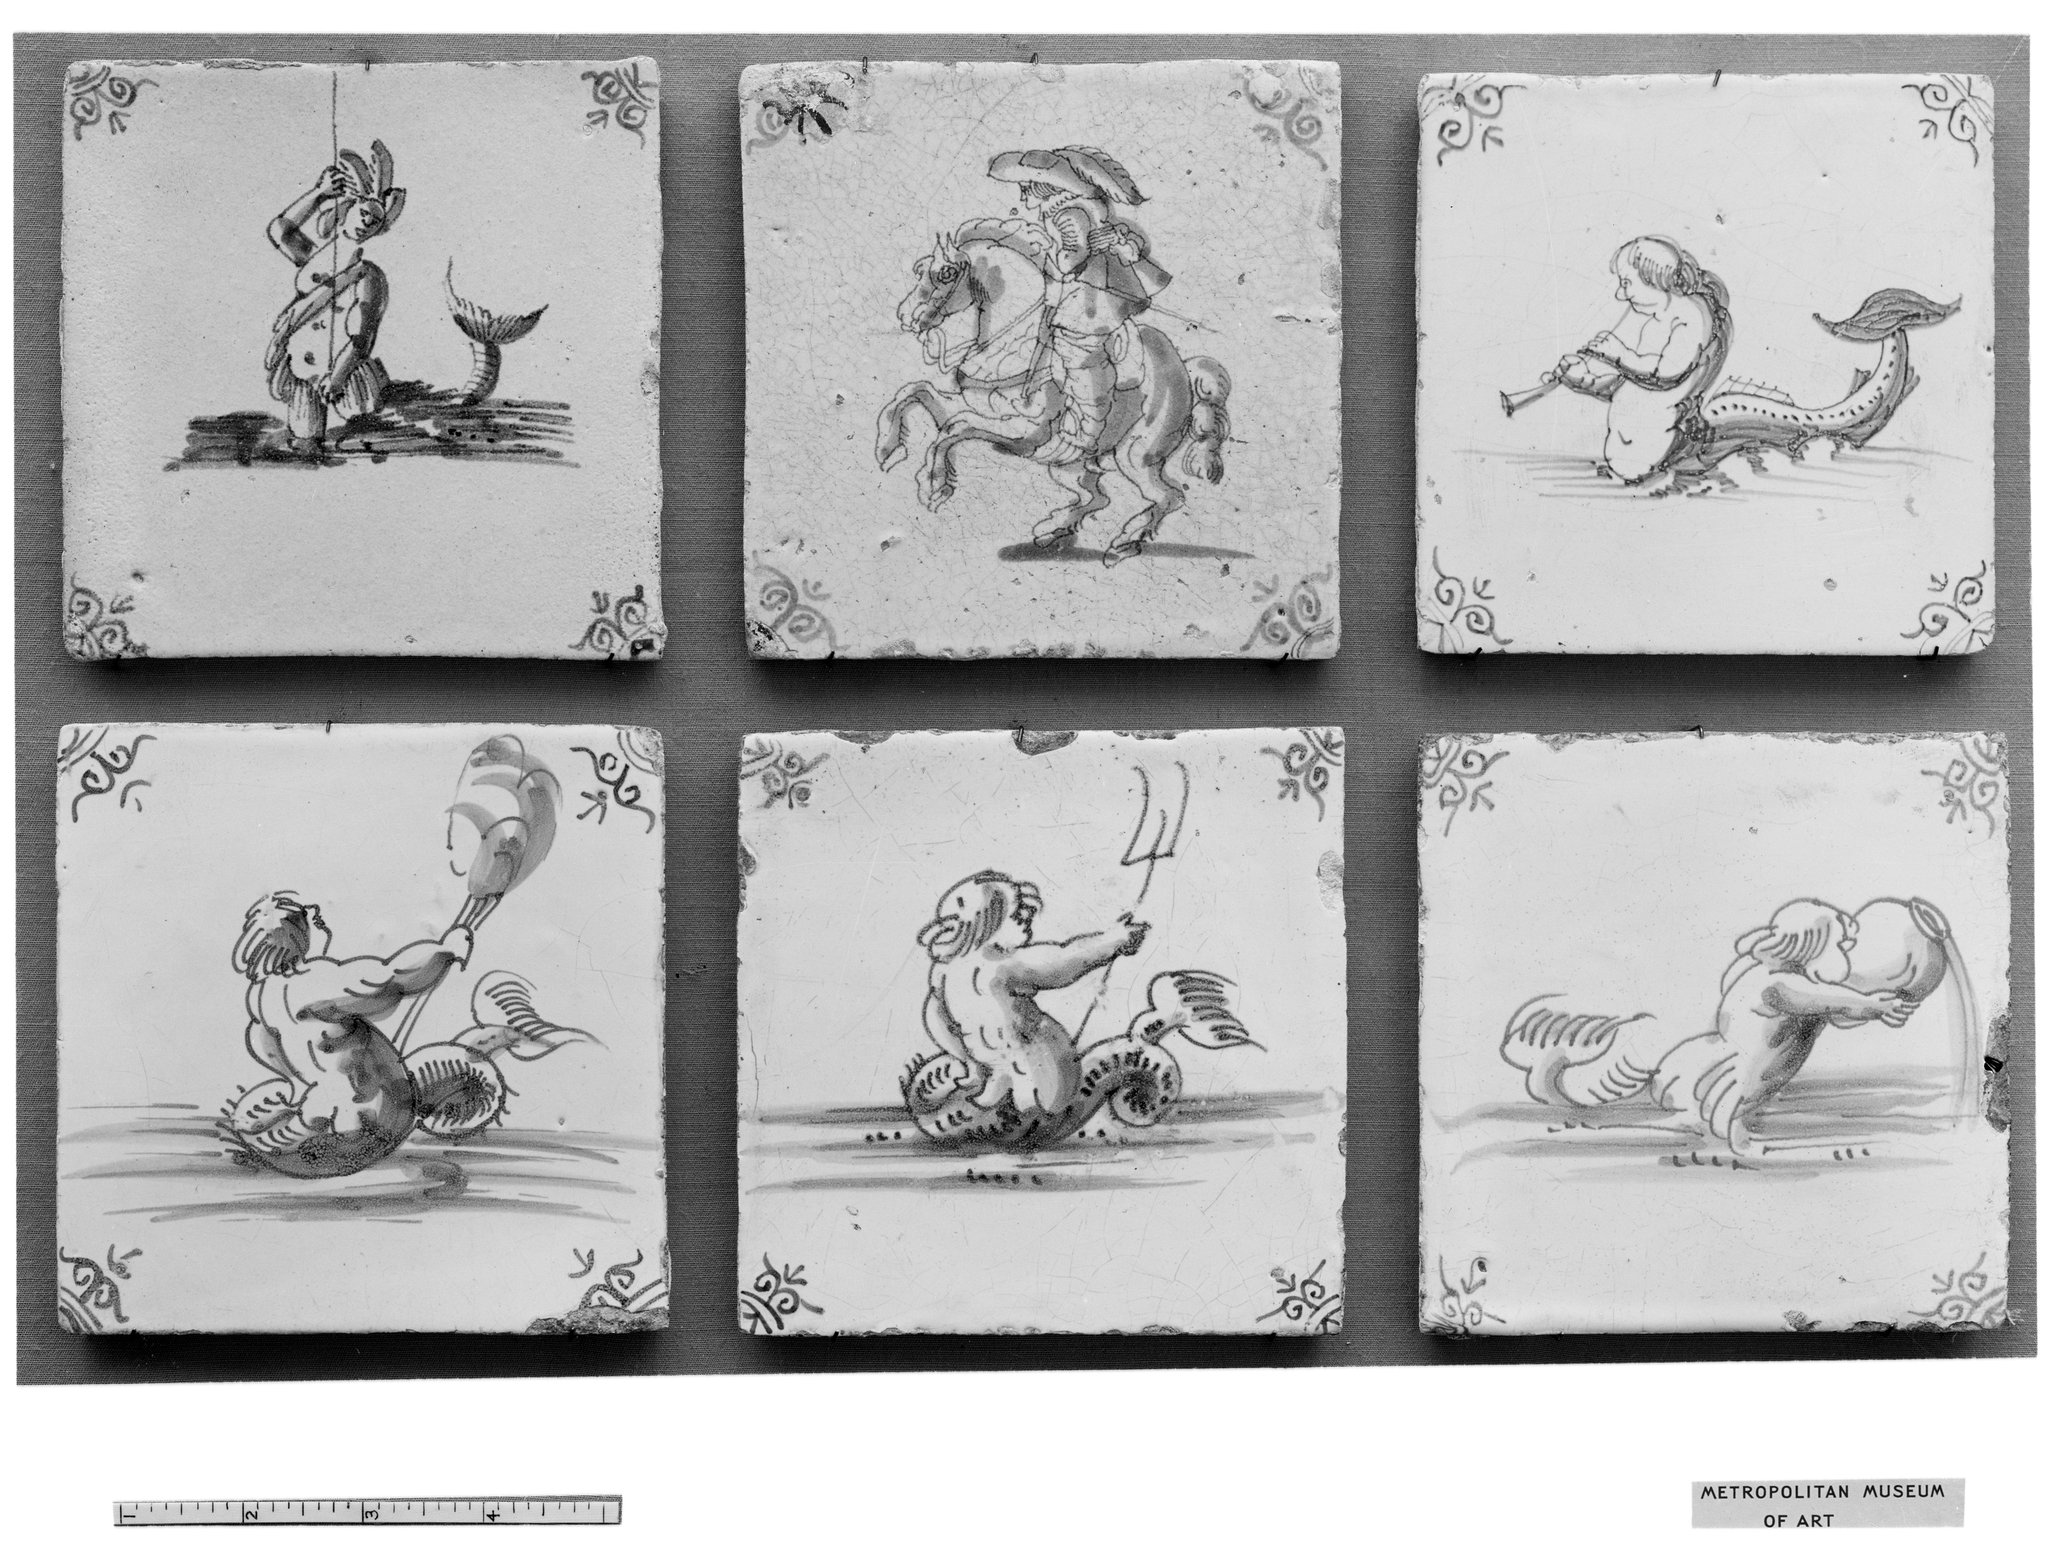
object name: tile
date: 1640-1660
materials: earthenware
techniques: glazing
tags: mermaids,horses